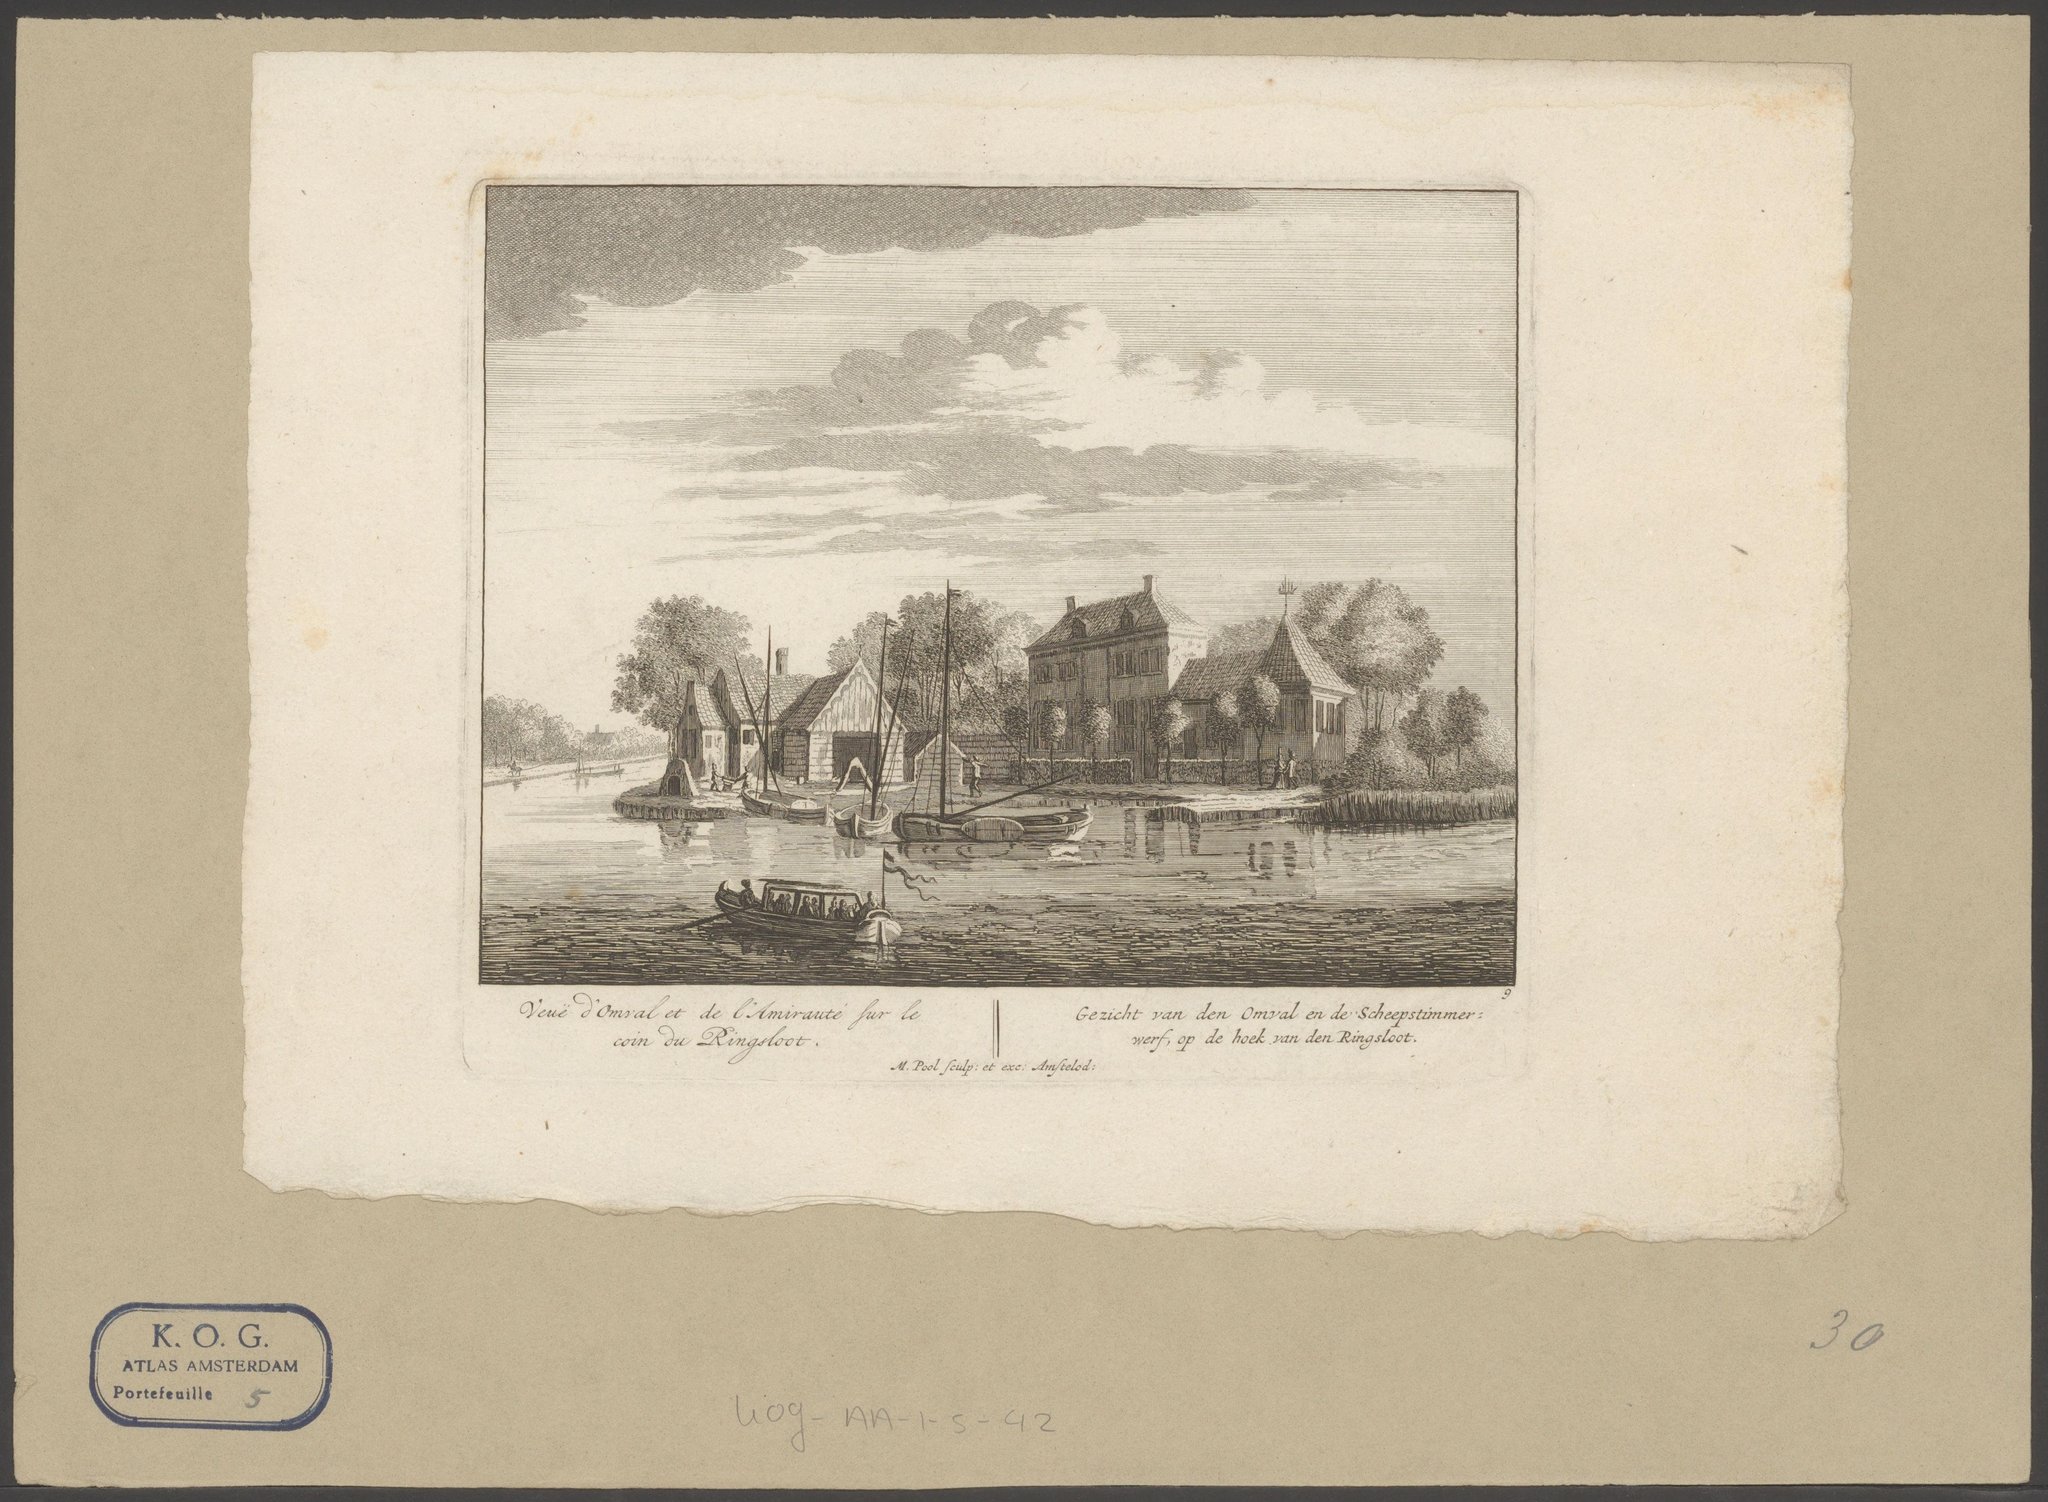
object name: print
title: Gezicht op de Amstel bij Huis De Omval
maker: matthijs pool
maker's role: print maker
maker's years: 1676-1740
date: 1708-1740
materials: paper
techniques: etching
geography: amsterdam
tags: sailing-ship, sailing-boat, city-view in general; 'veduta', river, boat propelled by man or animal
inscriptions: collector's mark: ‘5’ Lugt 1641b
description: Prent waarschijnlijk uit: Pool, Matthijs. Verscheyde gesigten van de vermaarde rievier de buyten Amstel van de stadt Amsterdam, tot het dorp Ouwerkerk (…) / Plusieurs veuës et perspectives de la fameuse riviére de Buyten-Amstel depuis Amsterdam jusqu'au village d'Ouwerkerk (…). Amsterdam: Matthijs Pool, z.j. [1708-1740].